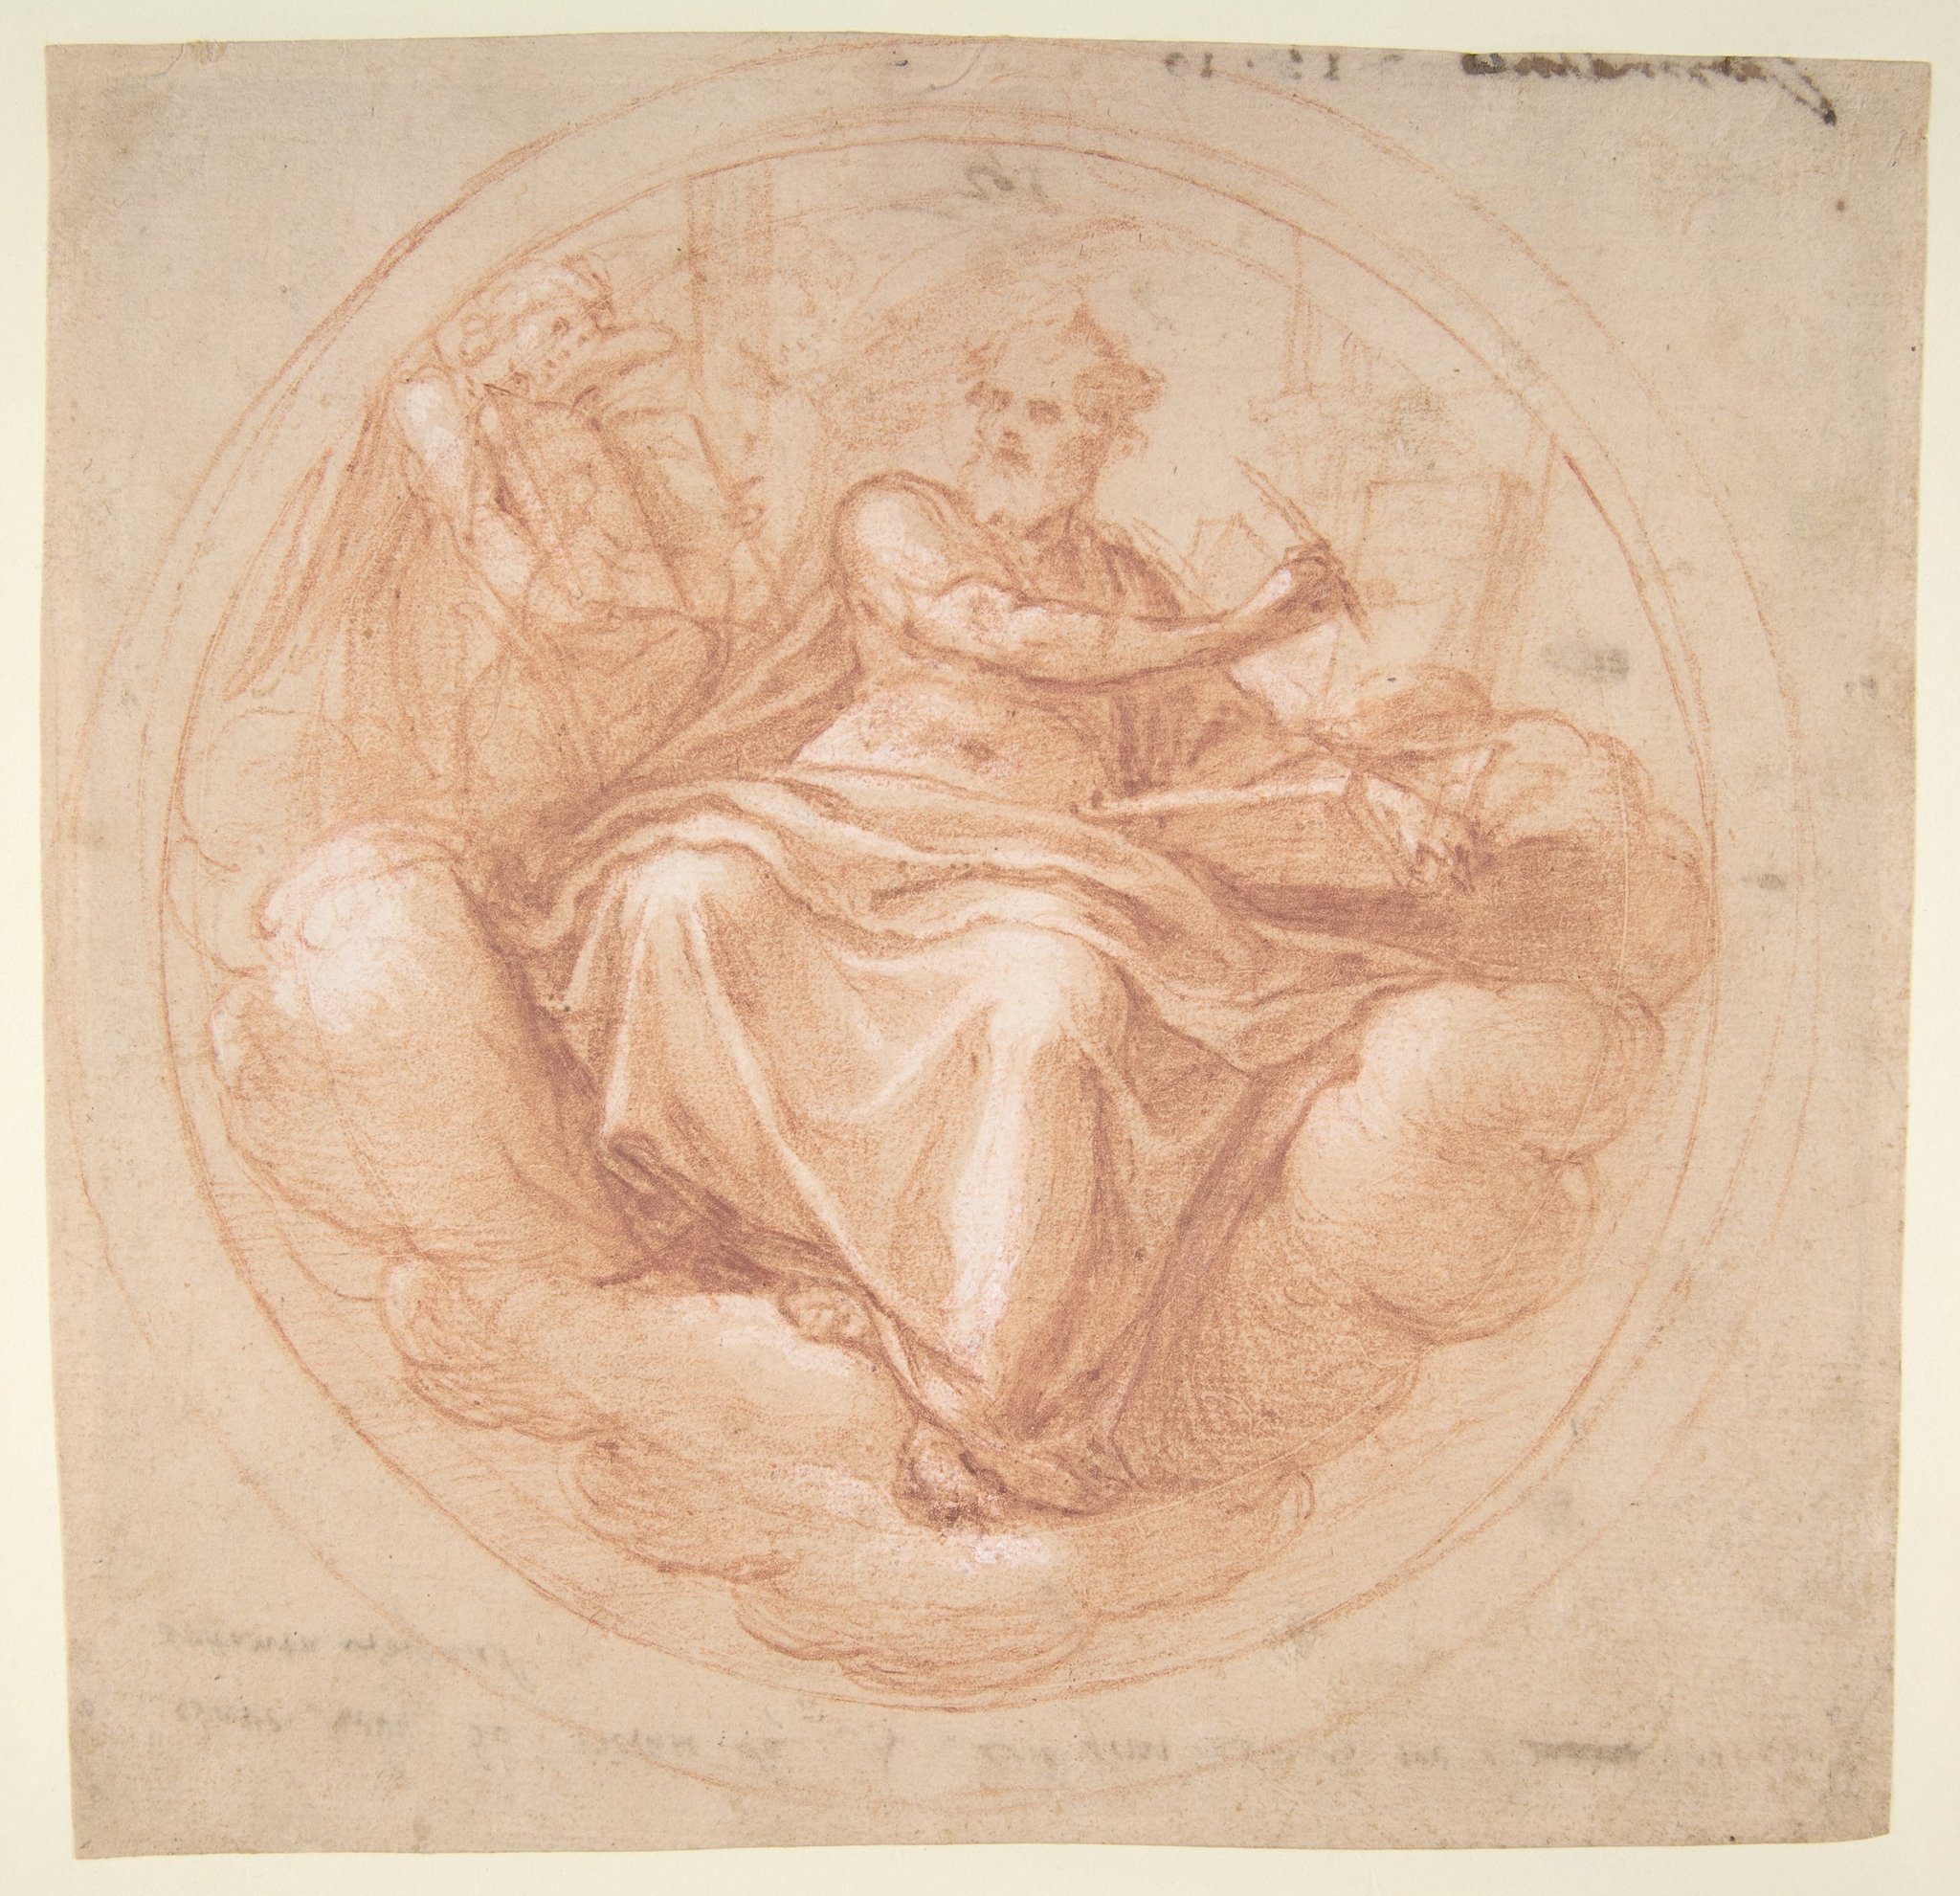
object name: drawing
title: Saint Mathew and the Angel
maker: cesare nebbia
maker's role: artist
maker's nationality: italian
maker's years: 1536-1614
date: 1536-1614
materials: chalk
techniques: highlighting, incising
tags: angels,saints